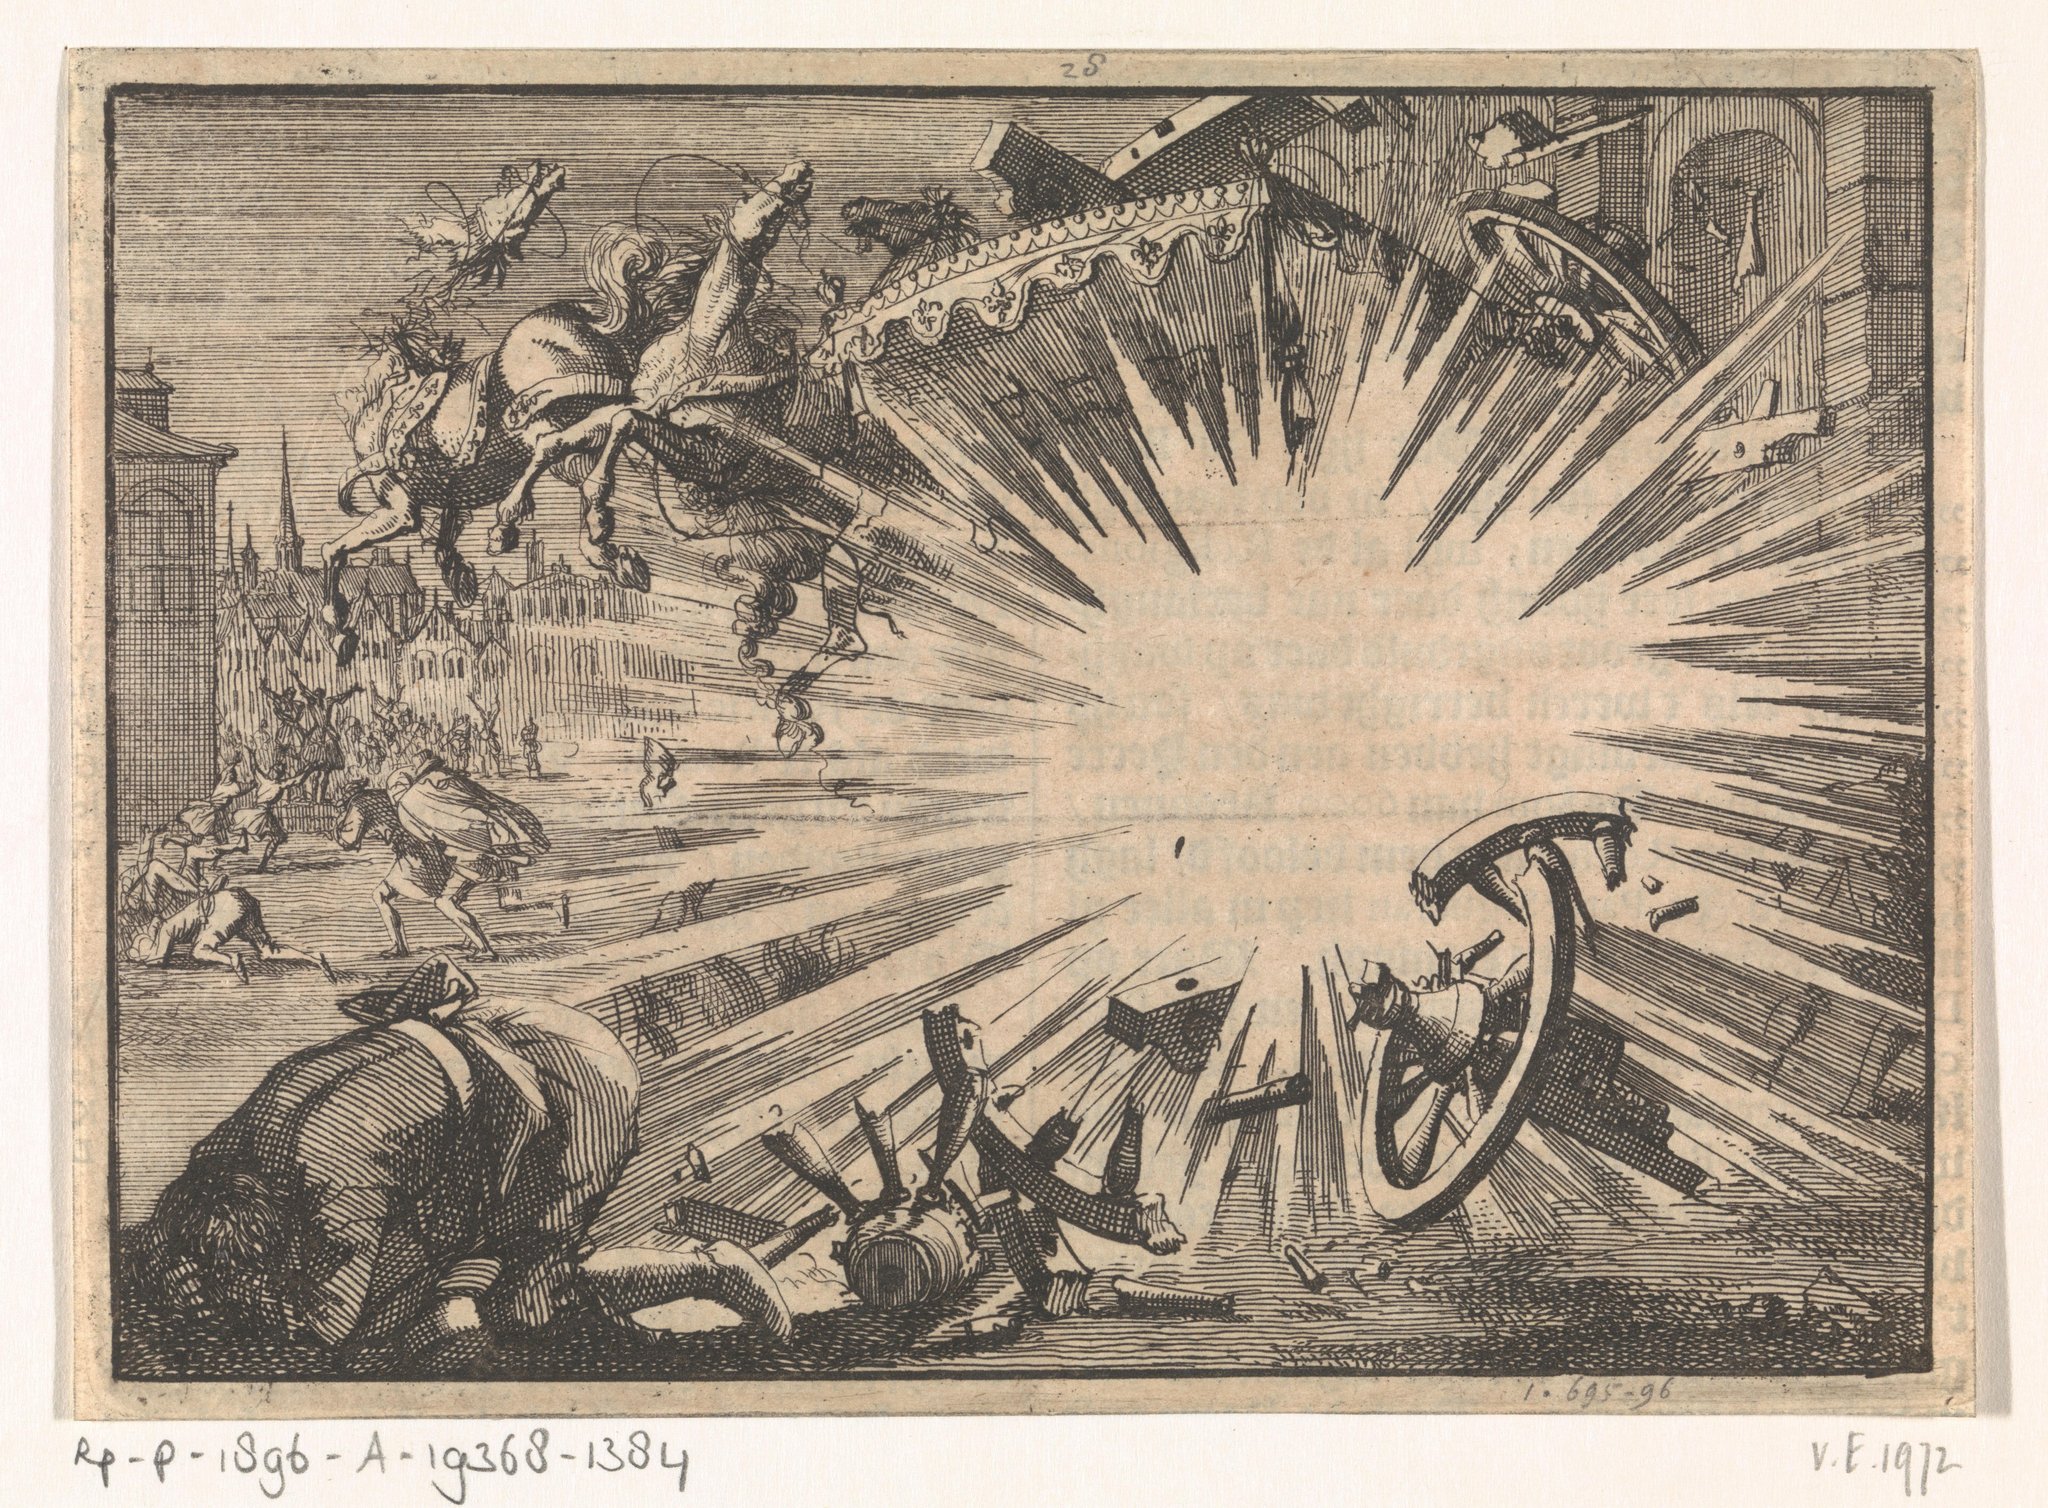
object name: print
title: Rijtuig en de paarden van koning Lodewijk XIII door ontploffing van een helse machine vernield, ca. 1625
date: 1698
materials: paper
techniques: etching, letterpress printing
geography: amsterdam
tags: lodewijk xiii (koning van frankrijk), four-wheeled, animal-drawn vehicle, e.g.: cab, carriage, coach, gunpowder disaster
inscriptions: collector's mark: Lugt 2228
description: Illustratie uit: Gottfried, Johann Ludwig. Historische kronyck; vervattende een (...) beschrijvingh der aldergedenckwaerdigste geschiedenissen des weerelds, van den aenvangh der scheppingh tot (...) 1576 (2 delen). Leiden: Pieter van der Aa, 1698, dl. I, p. 695.